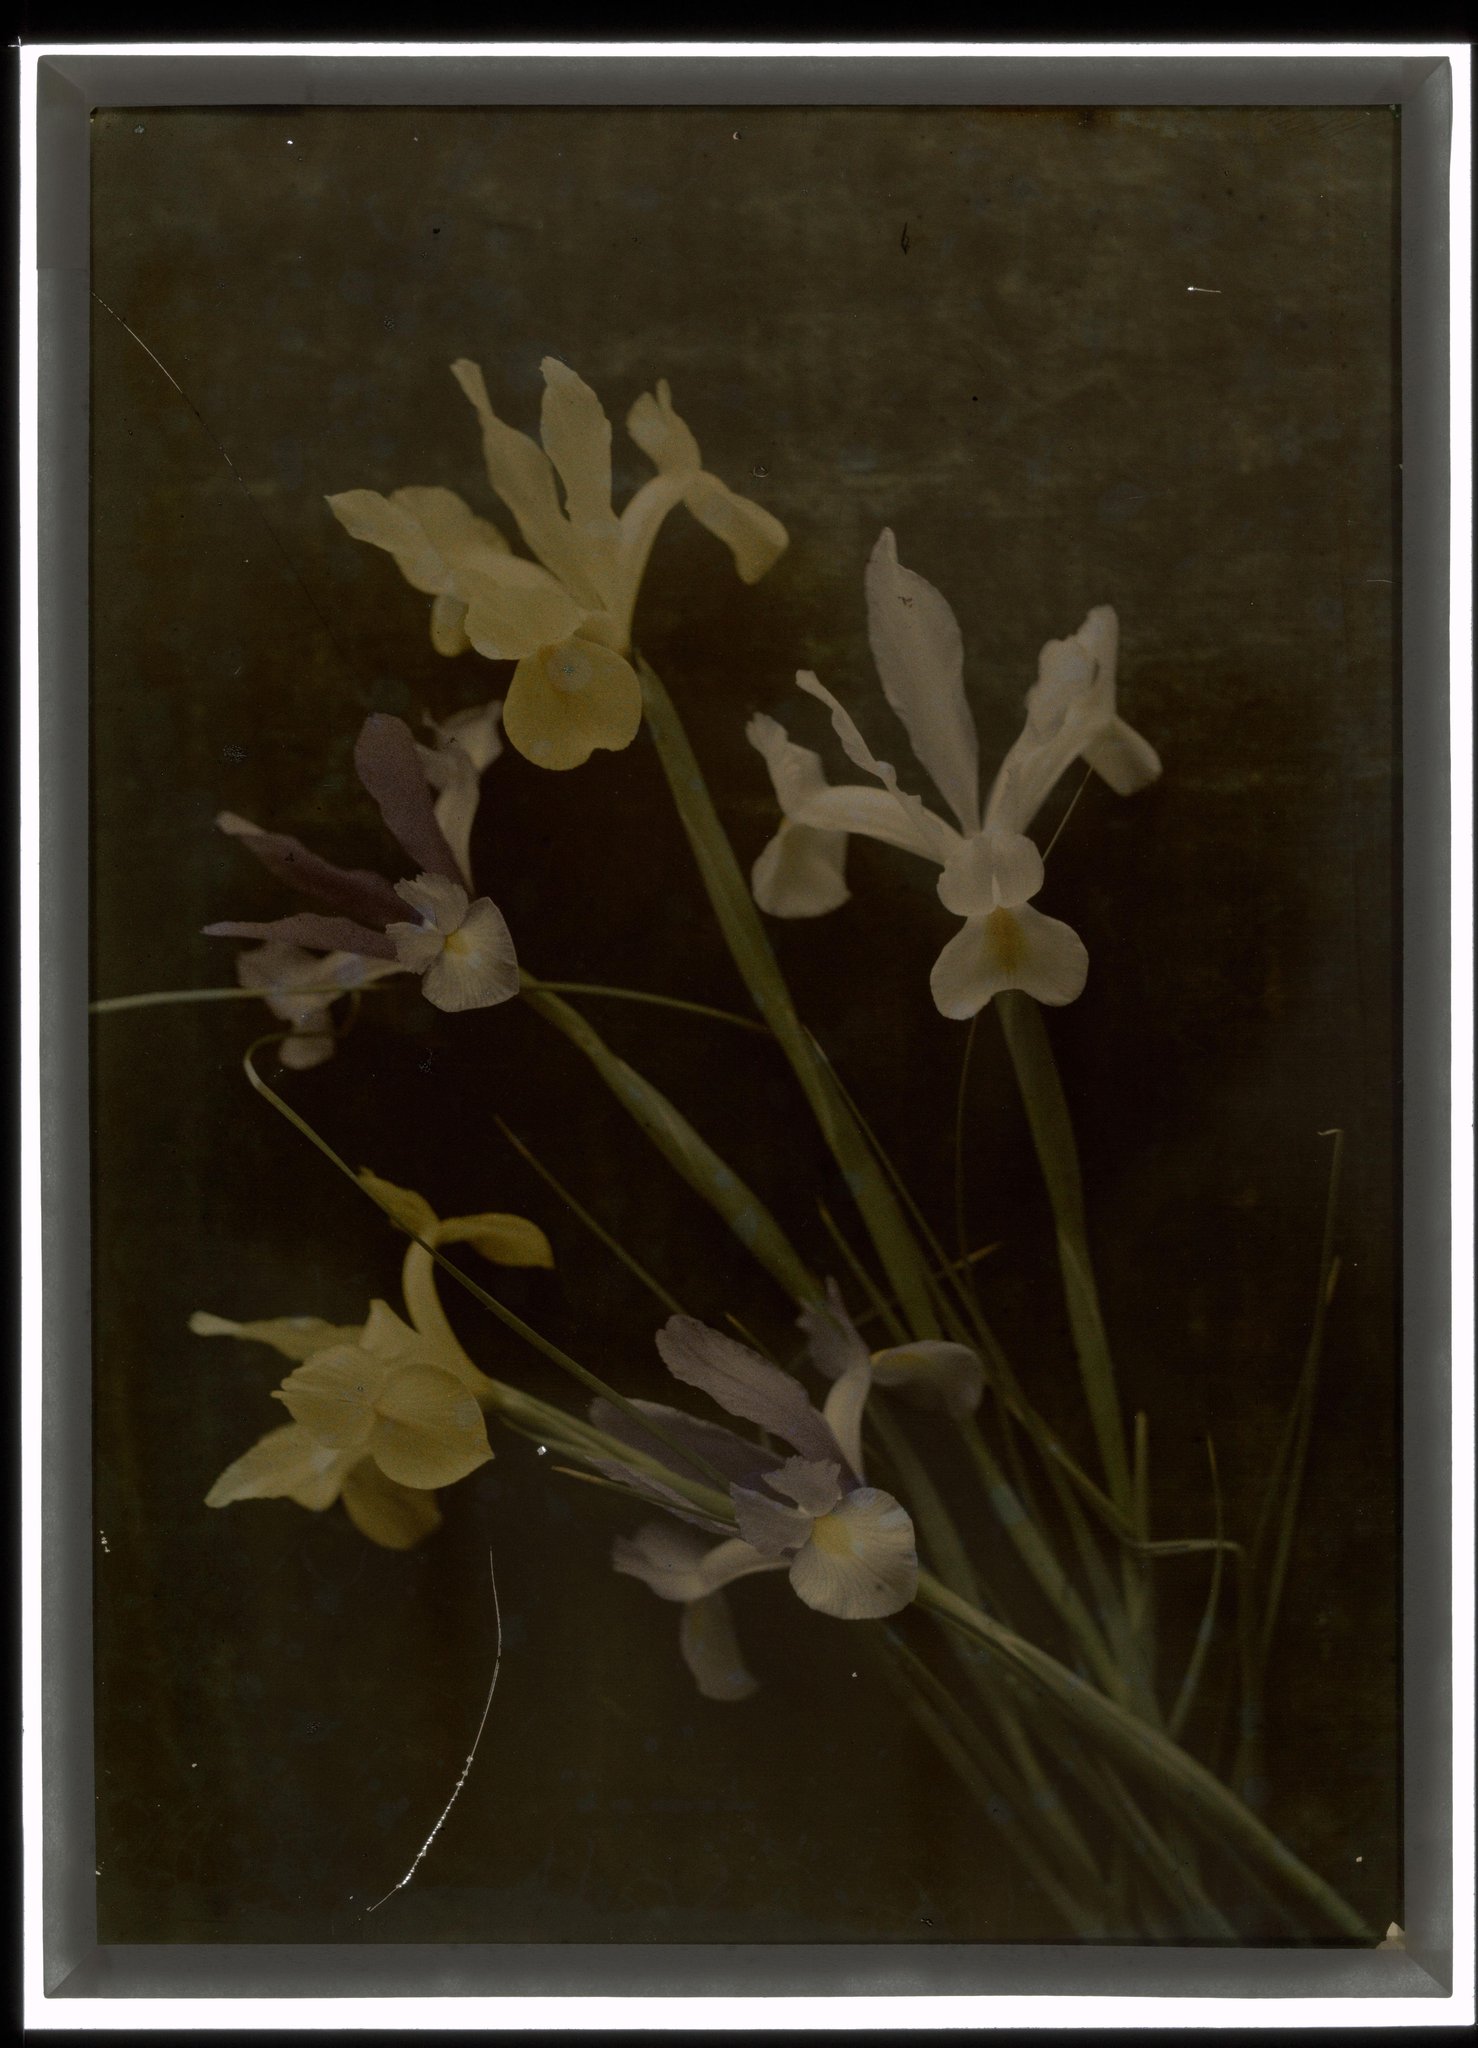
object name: photograph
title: Bloemstudie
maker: Anonymous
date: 1907-1935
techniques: autochrome process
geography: france